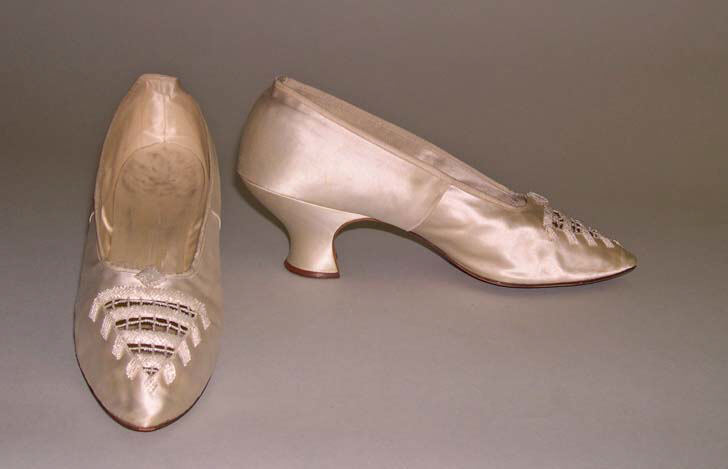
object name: wedding shoe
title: Wedding shoes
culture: american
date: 1889